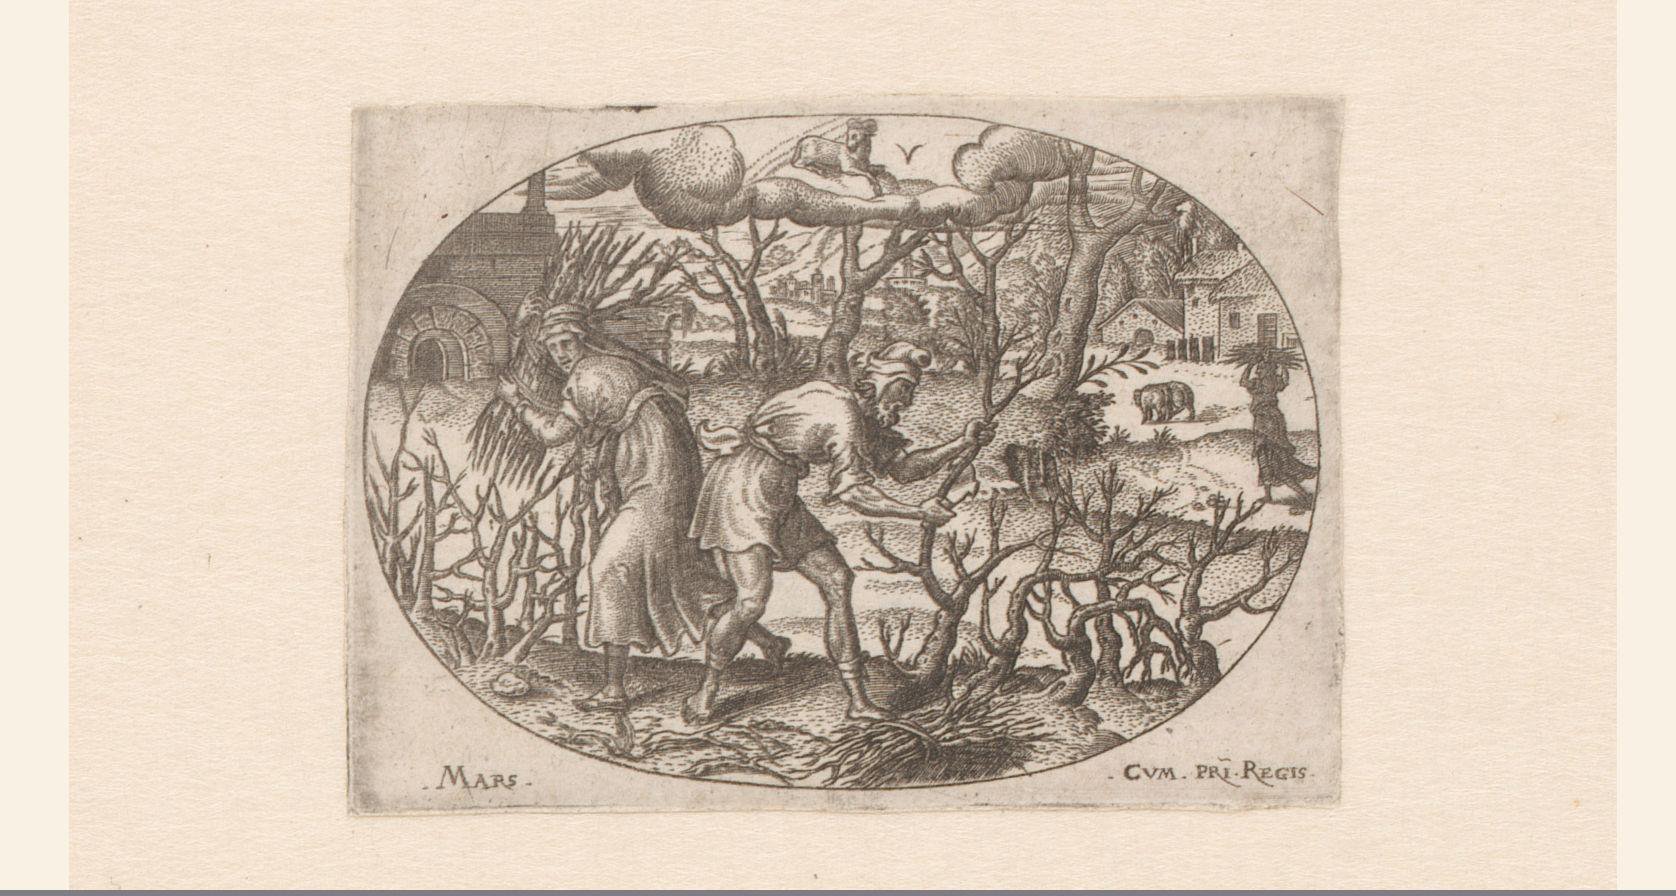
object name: print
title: Twaalf maanden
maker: etienne delaune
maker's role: draughtsman, goldsmith, print maker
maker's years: 1519-1583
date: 1568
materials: paper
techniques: engraving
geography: france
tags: aquarius (zodiacal sign of january), january and its 'labours' (+ with zodiacal signs)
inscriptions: collector's mark: Lugt 240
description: Maakt deel uit van een twaalfdelige serie van de twaalf maanden met tekens van de dierenriem, in ovale vorm. In de collectie van het Rijksmuseum bevindt zich de complete serie.